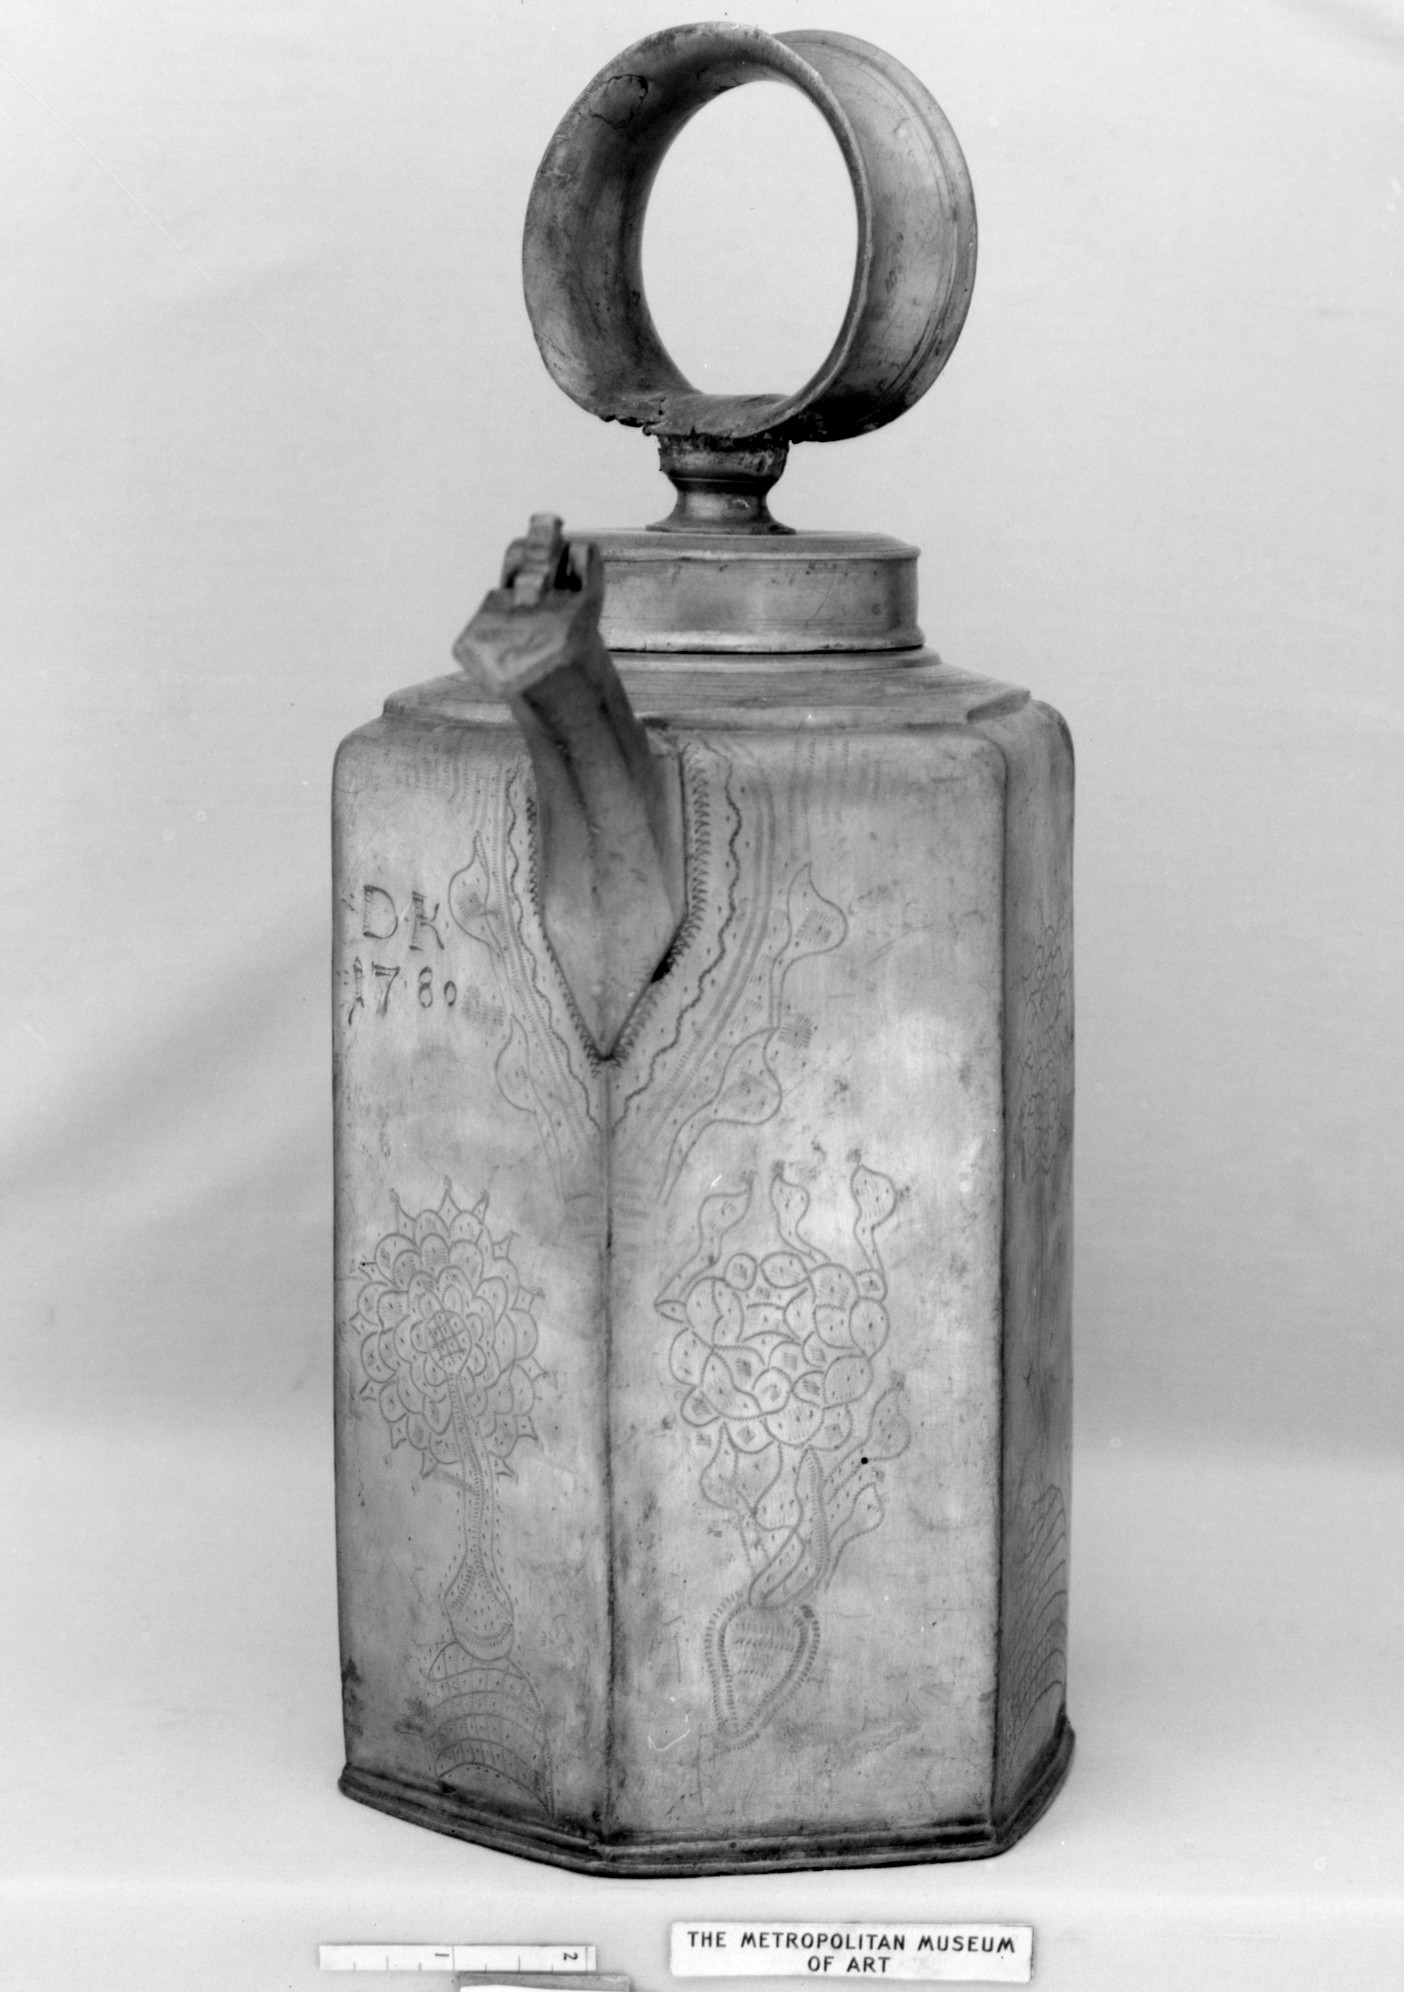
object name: wine can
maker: abraham hiller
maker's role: maker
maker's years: 1719-1798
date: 1780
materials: pewter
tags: flowers